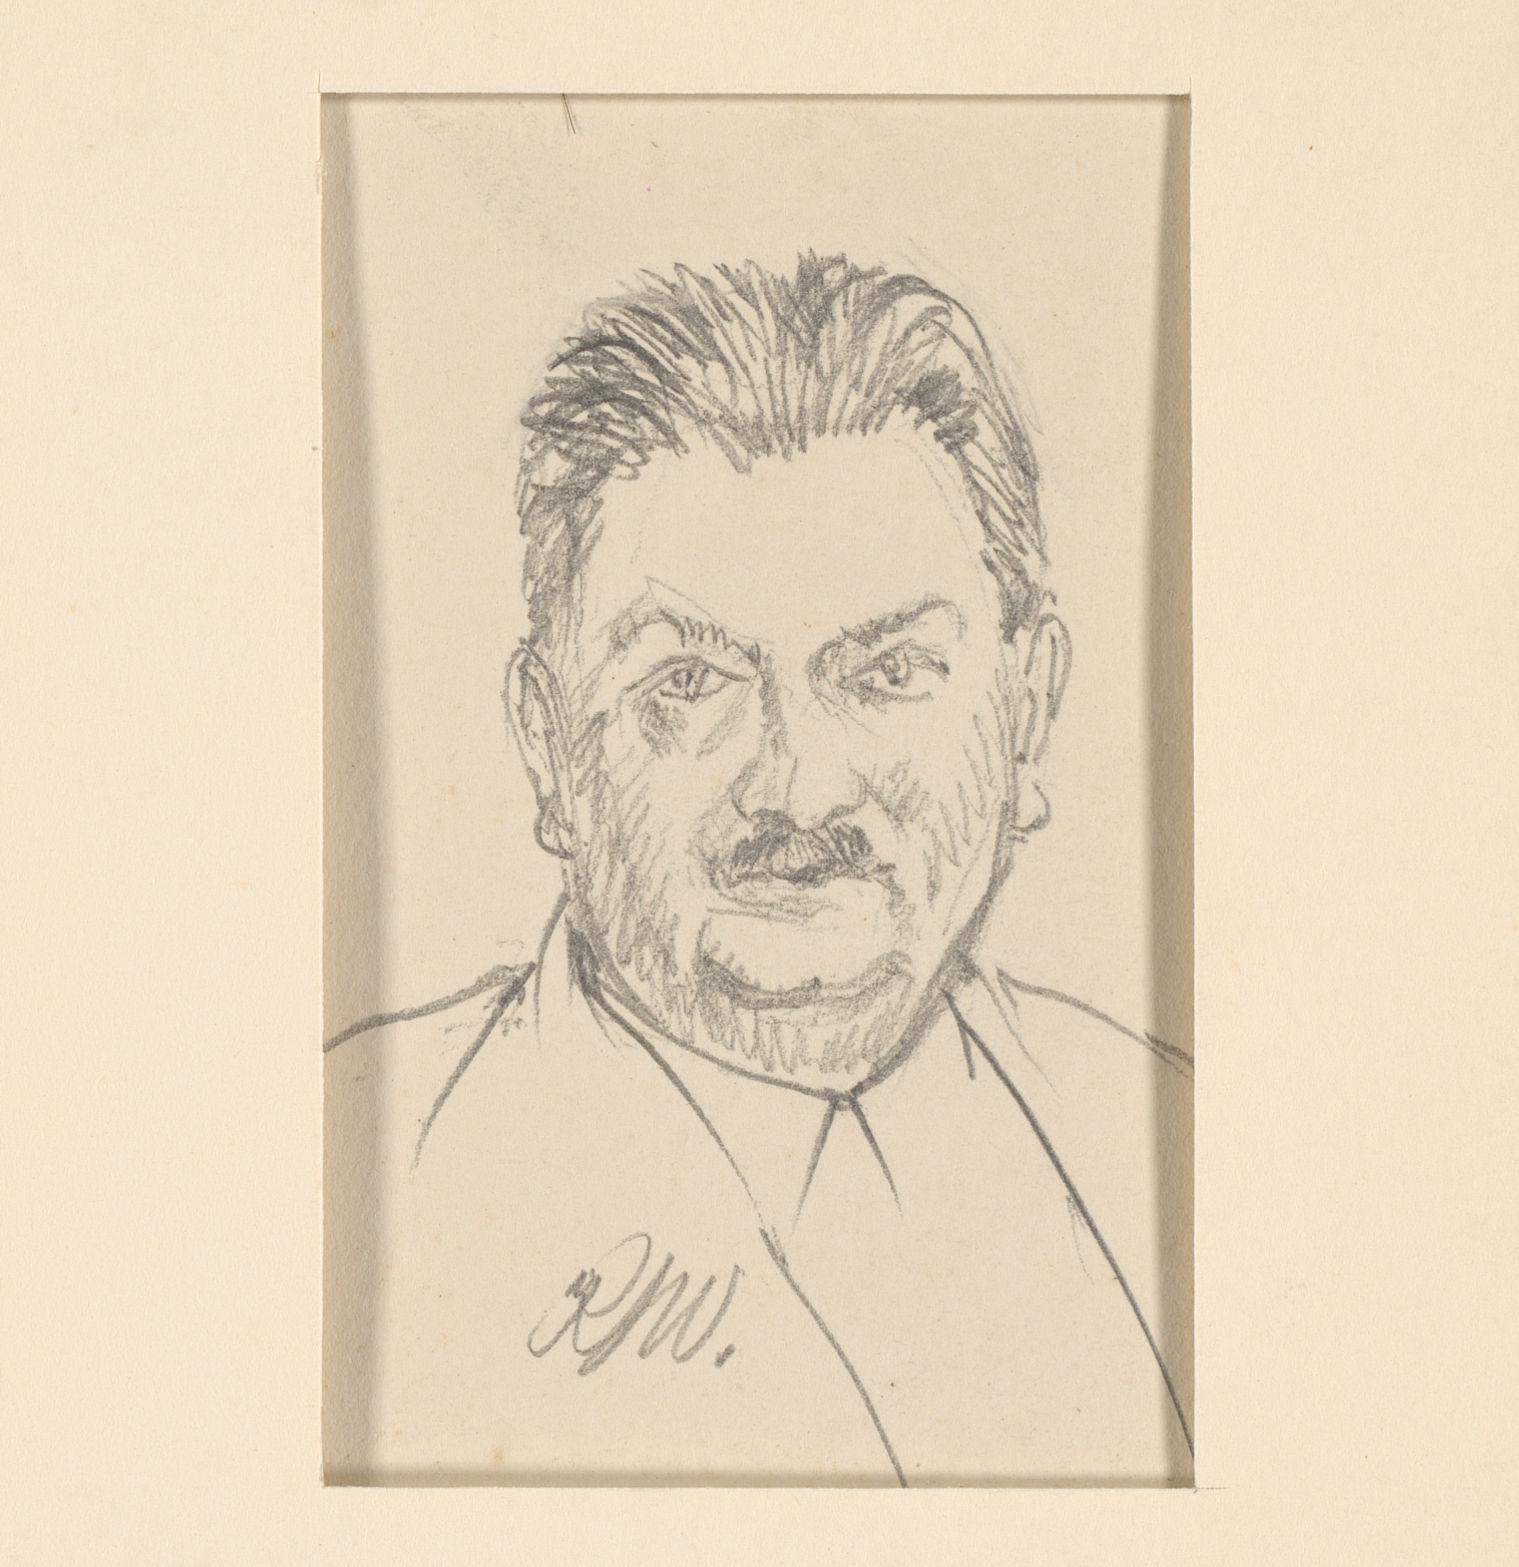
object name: drawing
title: Portret van Wilhelmus Lambertus Wijmans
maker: Anonymous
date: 1920-1976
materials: paper, pencil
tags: utrecht, draughtsman, wilhelmus lambertus wijmans, portrait, self-portrait of artist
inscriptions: signature: ‘K[...]W.’